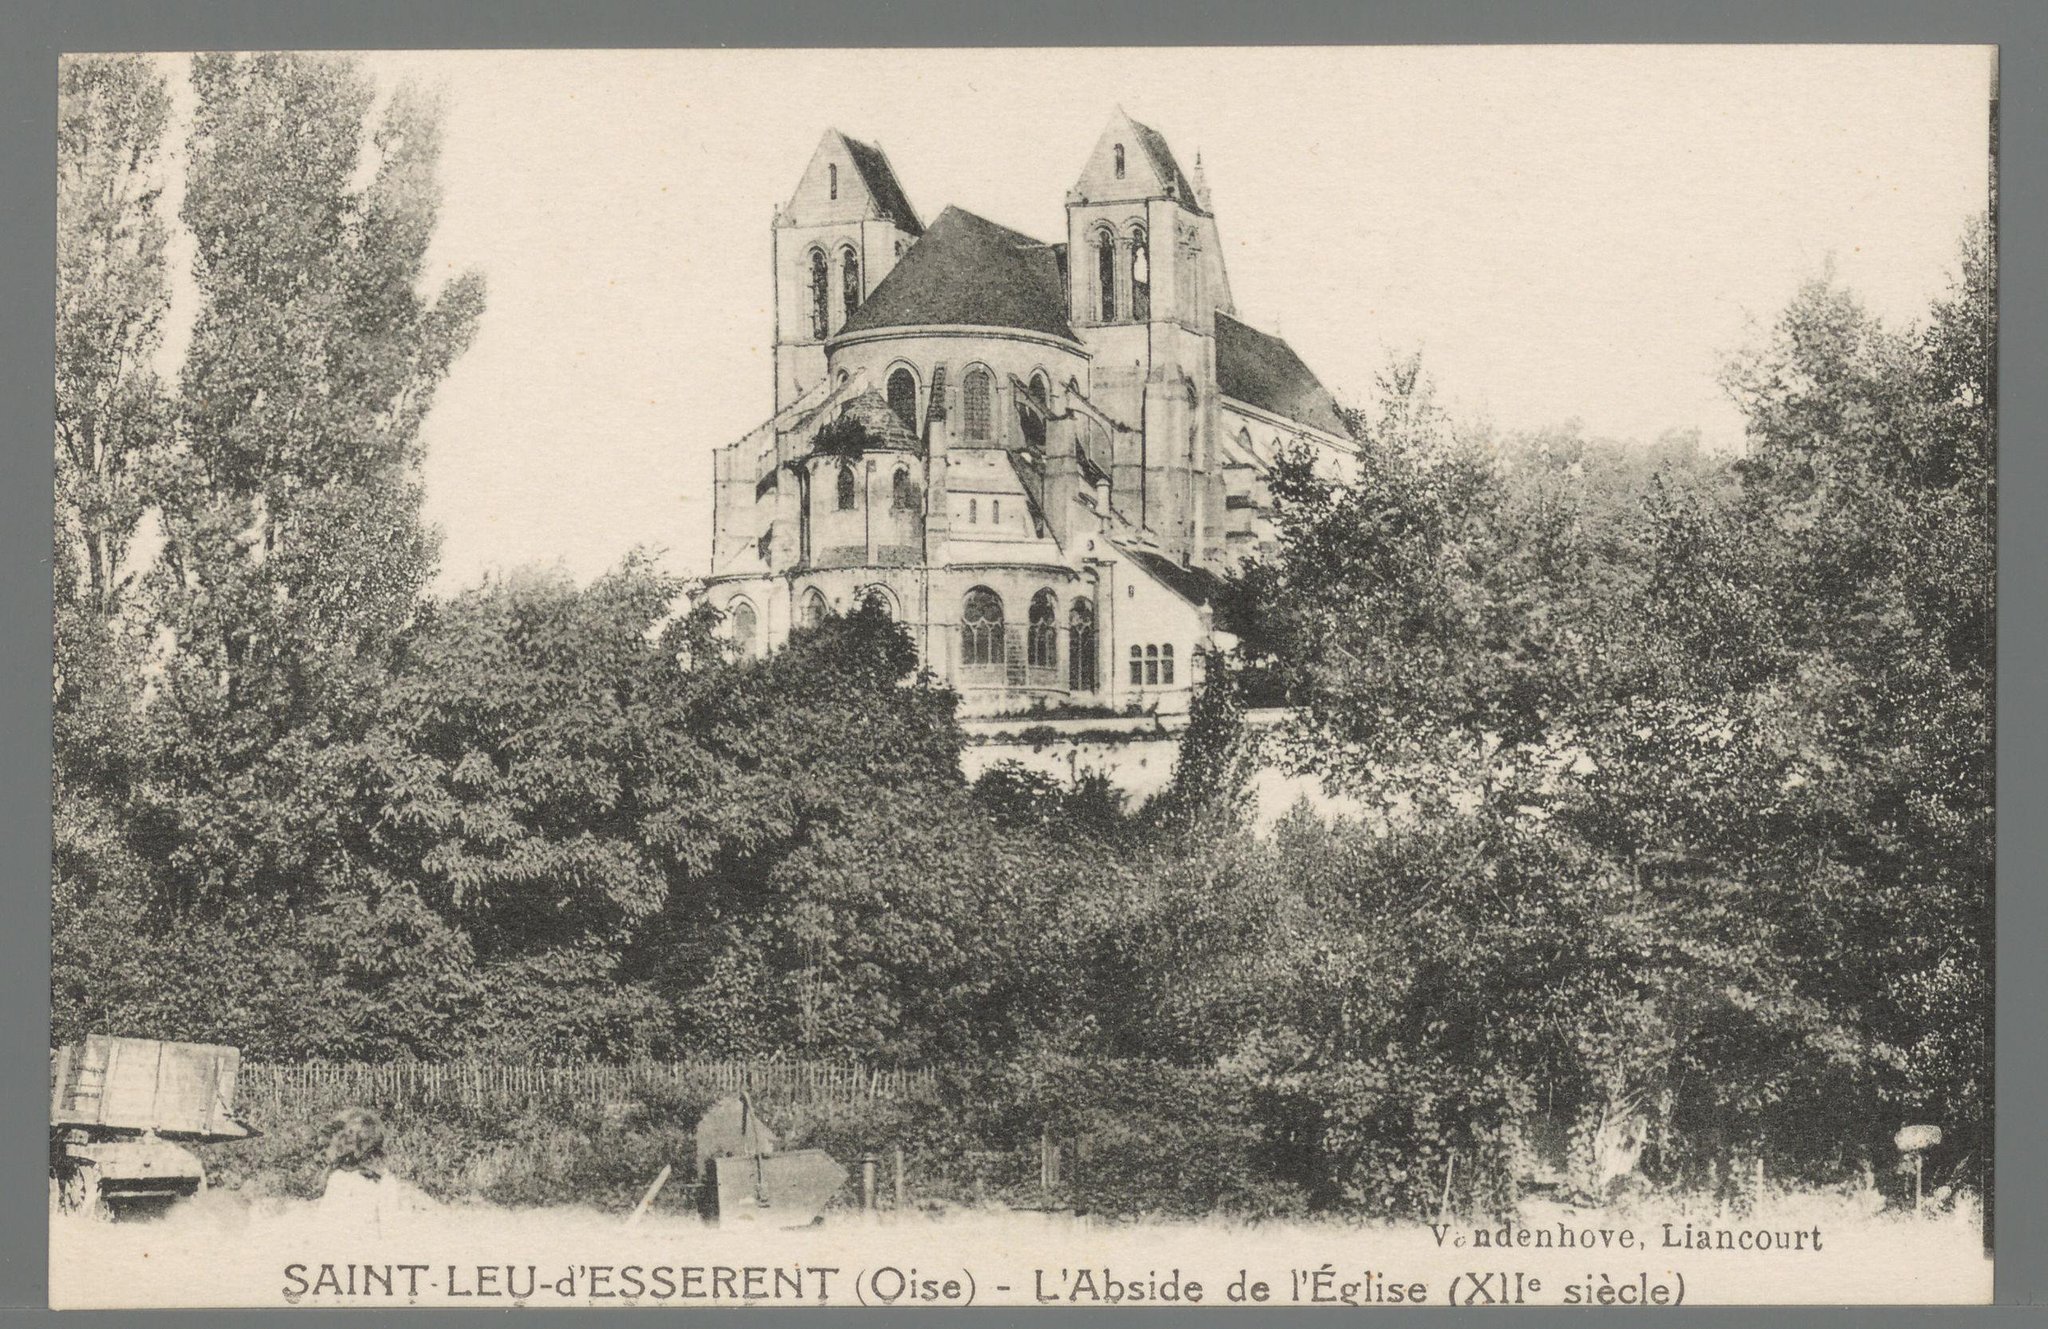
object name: photomechanical print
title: Saint-Leu-d'Esserent (Oise) - L'Abside de l'Église (XIIe siècle)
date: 1903-1930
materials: cardboard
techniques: photograph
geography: saint-leu-d'esserent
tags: church (exterior)